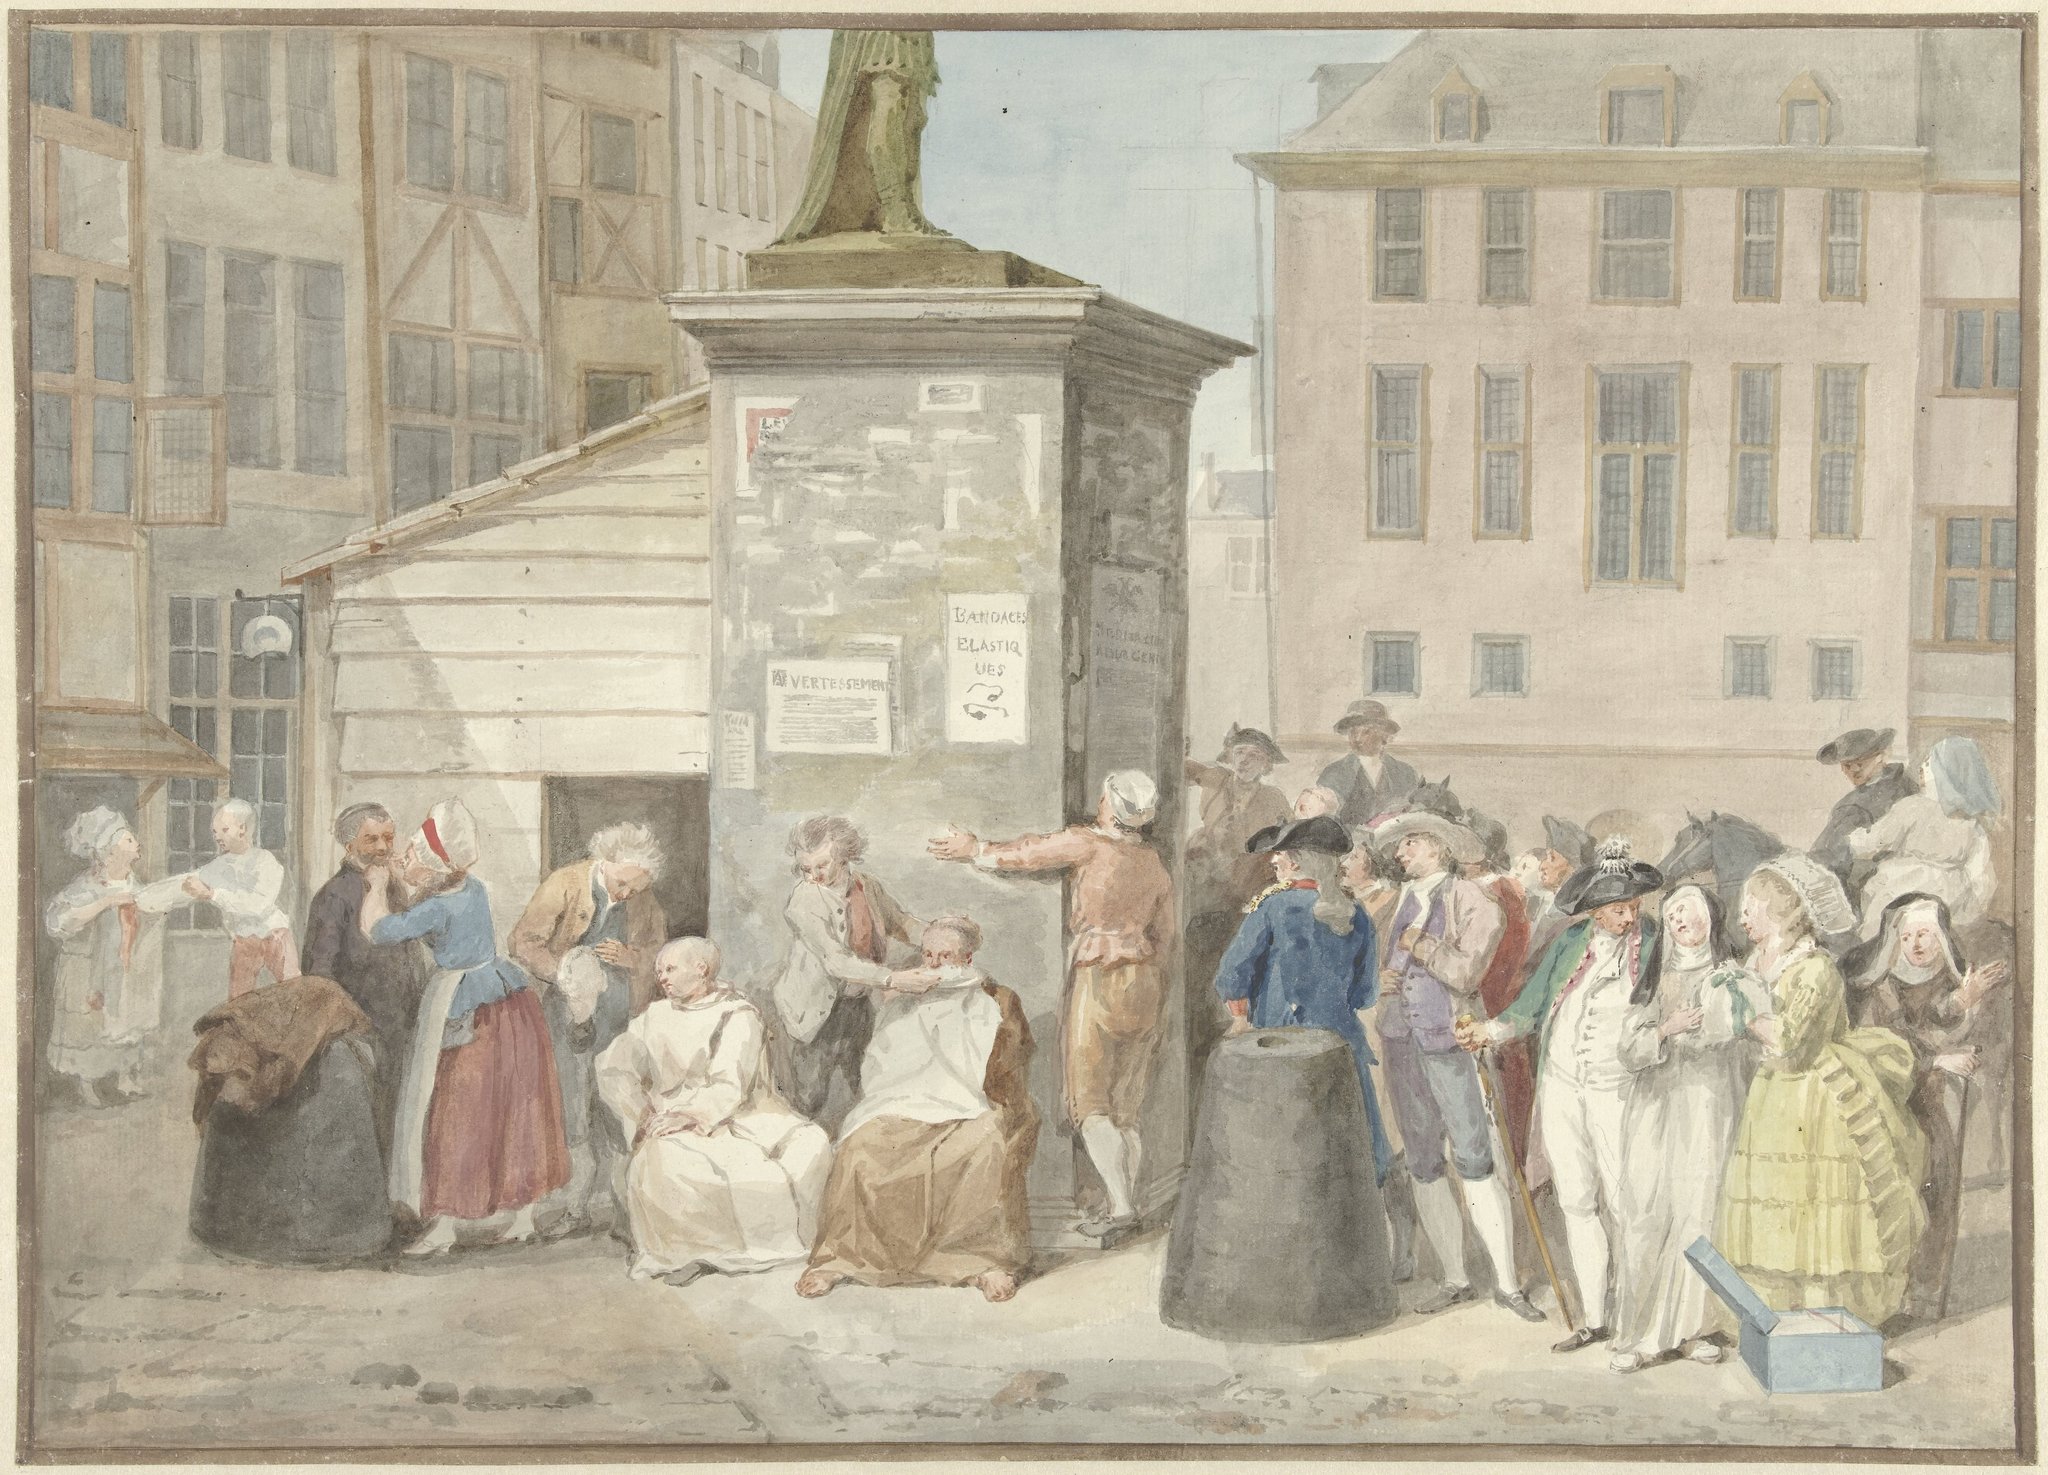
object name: drawing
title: Plein met monniken en nonnen tijdens de revolutie in België, 20 oktober 1787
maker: aert schouman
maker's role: draughtsman, painter, print maker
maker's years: 1710-1792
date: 1787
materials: ink, paper, watercolor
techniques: brush, pen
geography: northern netherlands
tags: shaving, being shaved, southern netherlands, brabant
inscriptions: inscription: ‘d 20 octob: 1787 / A. Schouman fecit na Davranse van Luijk van geboorten et- / Defranc’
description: Gebeurtenis tijdens de revolutie in België, 20 oktober 1787; op een plein in een stad worden monniken geschoren en van hun pijen ontdaan. Rechts wachten enkele nonnen.